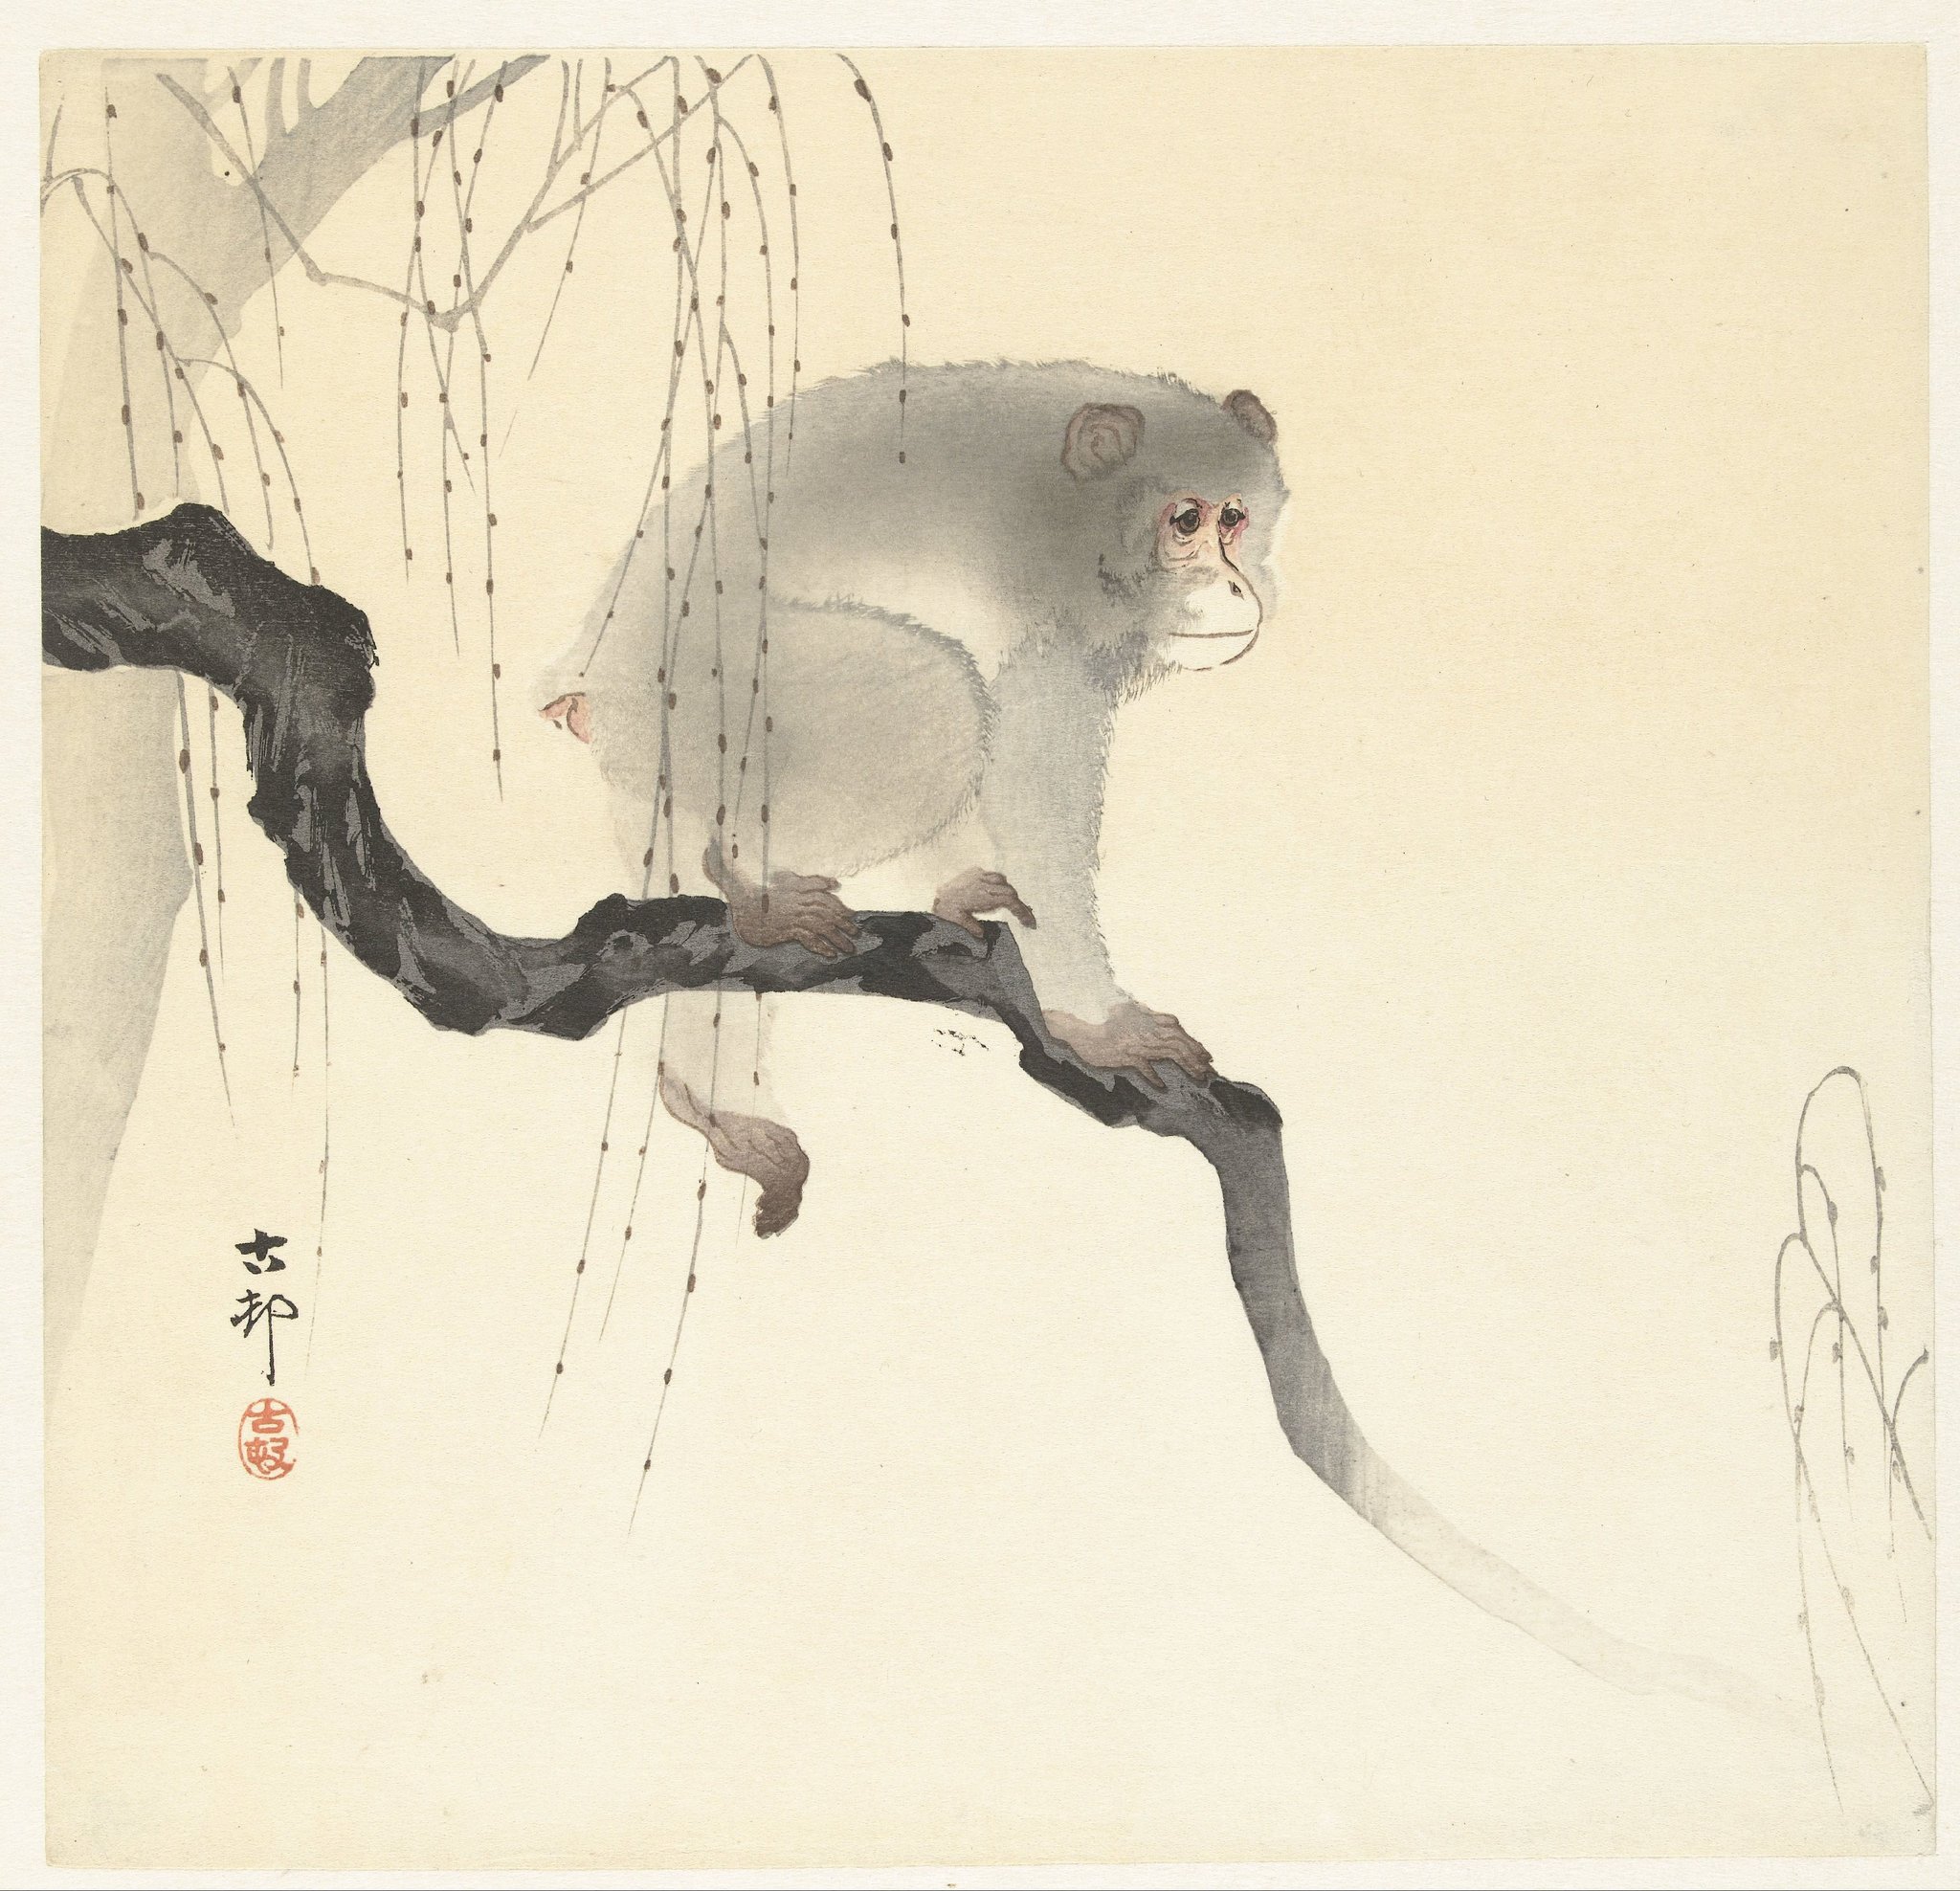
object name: print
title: Aap op boomtak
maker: ohara koson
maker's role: print maker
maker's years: 1877-1945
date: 1900-1930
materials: paper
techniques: woodcut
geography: japan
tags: monkeys, apes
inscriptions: collector's mark: Lugt 2228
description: Voor ander exemplaar van dezelfde prent zie RP-P-1977-128